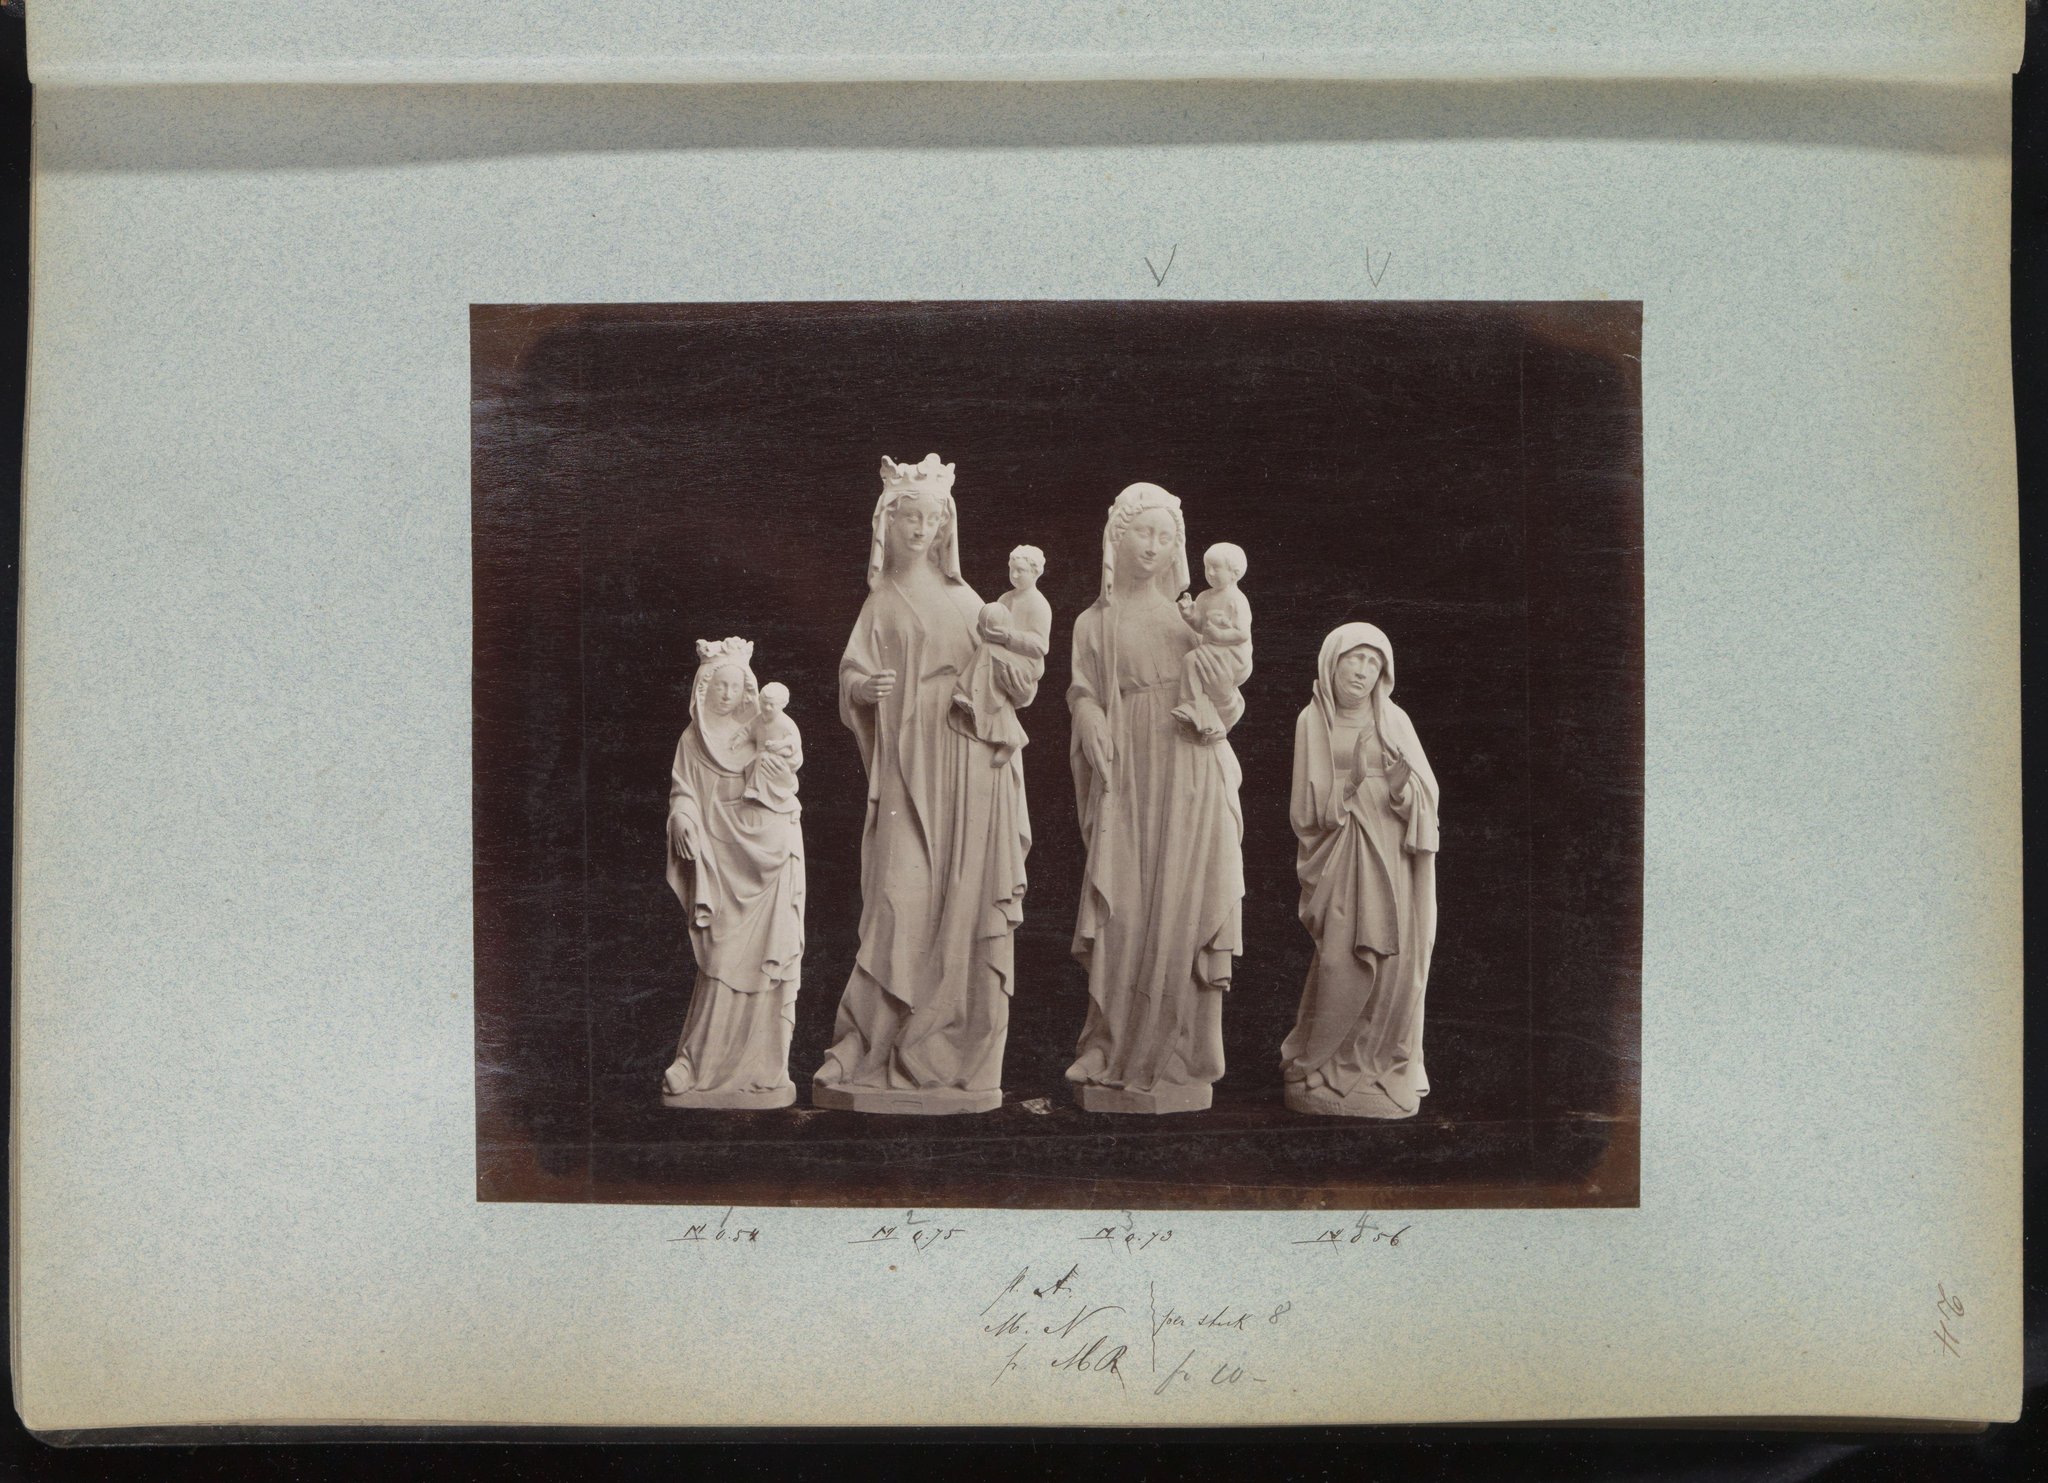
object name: photograph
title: Vier gipsen afgietsels van sculpturen, waarvan drie van Maria met kind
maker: Anonymous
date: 1875-1900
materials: paper, photographic support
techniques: albumen print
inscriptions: annotation: ‘M 0.54 M 0.75 M 0.73 M 0.56’, annotation